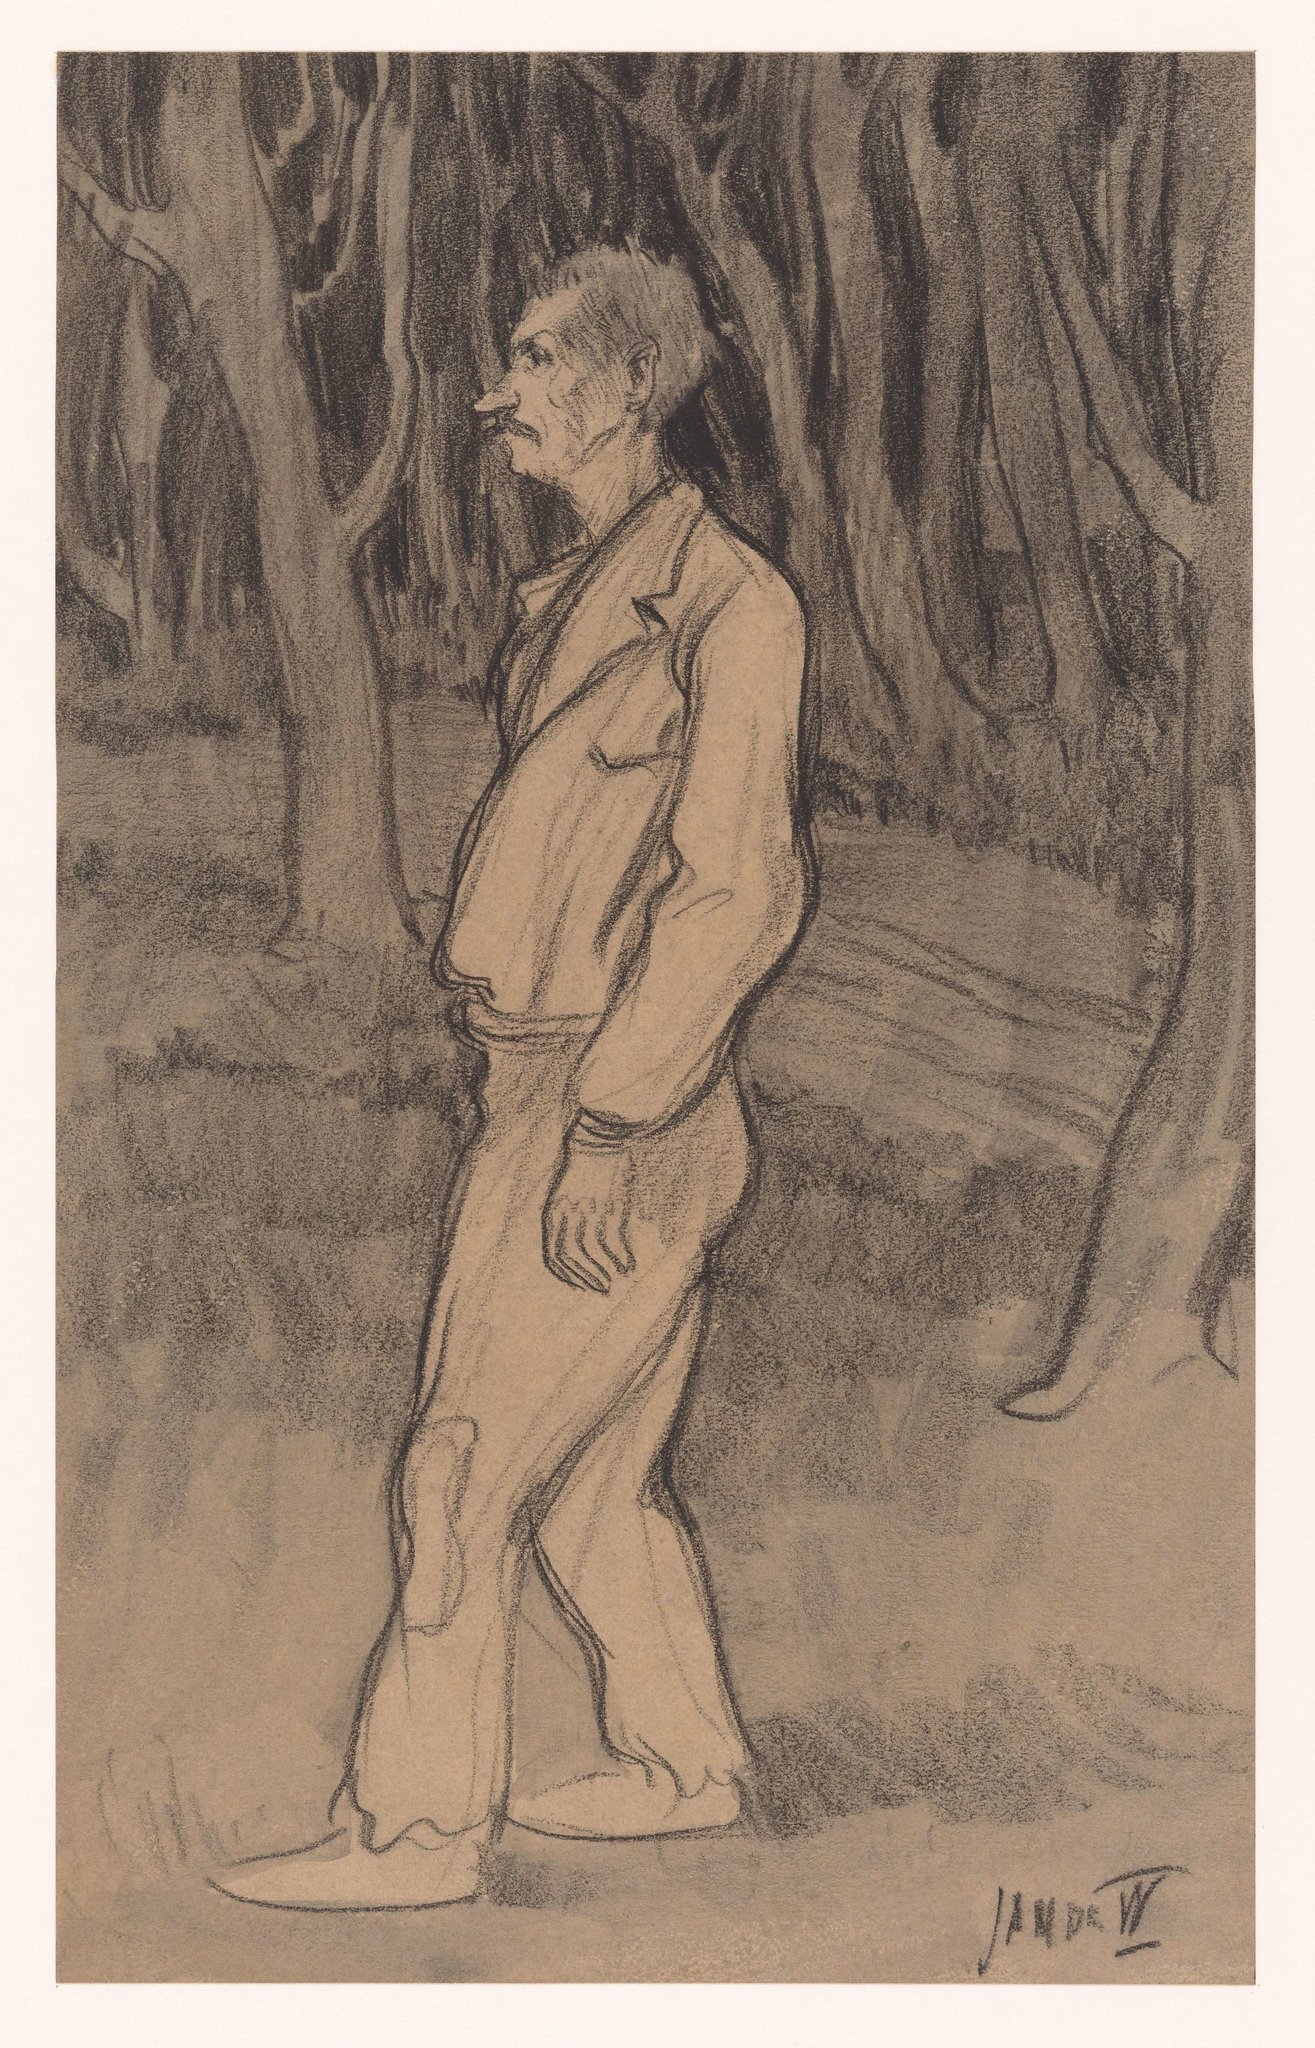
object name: drawing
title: Arbeider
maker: jan de waardt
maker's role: draughtsman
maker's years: 1871-1909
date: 1889-1899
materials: chalk, ink, paper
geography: netherlands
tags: working class, labourers, netherlands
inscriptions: signature: ‘Jan de W’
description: Man, in profiel naar links, ten voeten uit, lopend in een donker bos.